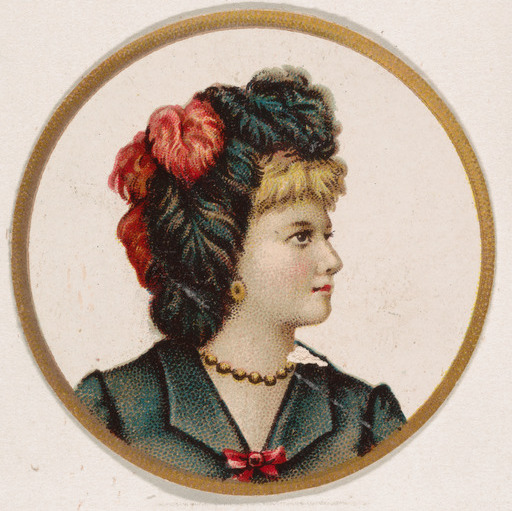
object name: print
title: Woman wearing hat with black and red feathers, from the Novelties series (N228, Type 2) issued by Kinney Bros.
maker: kinney brothers tobacco company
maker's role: publisher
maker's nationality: american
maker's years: 1869-2011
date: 1889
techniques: color lithograph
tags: women